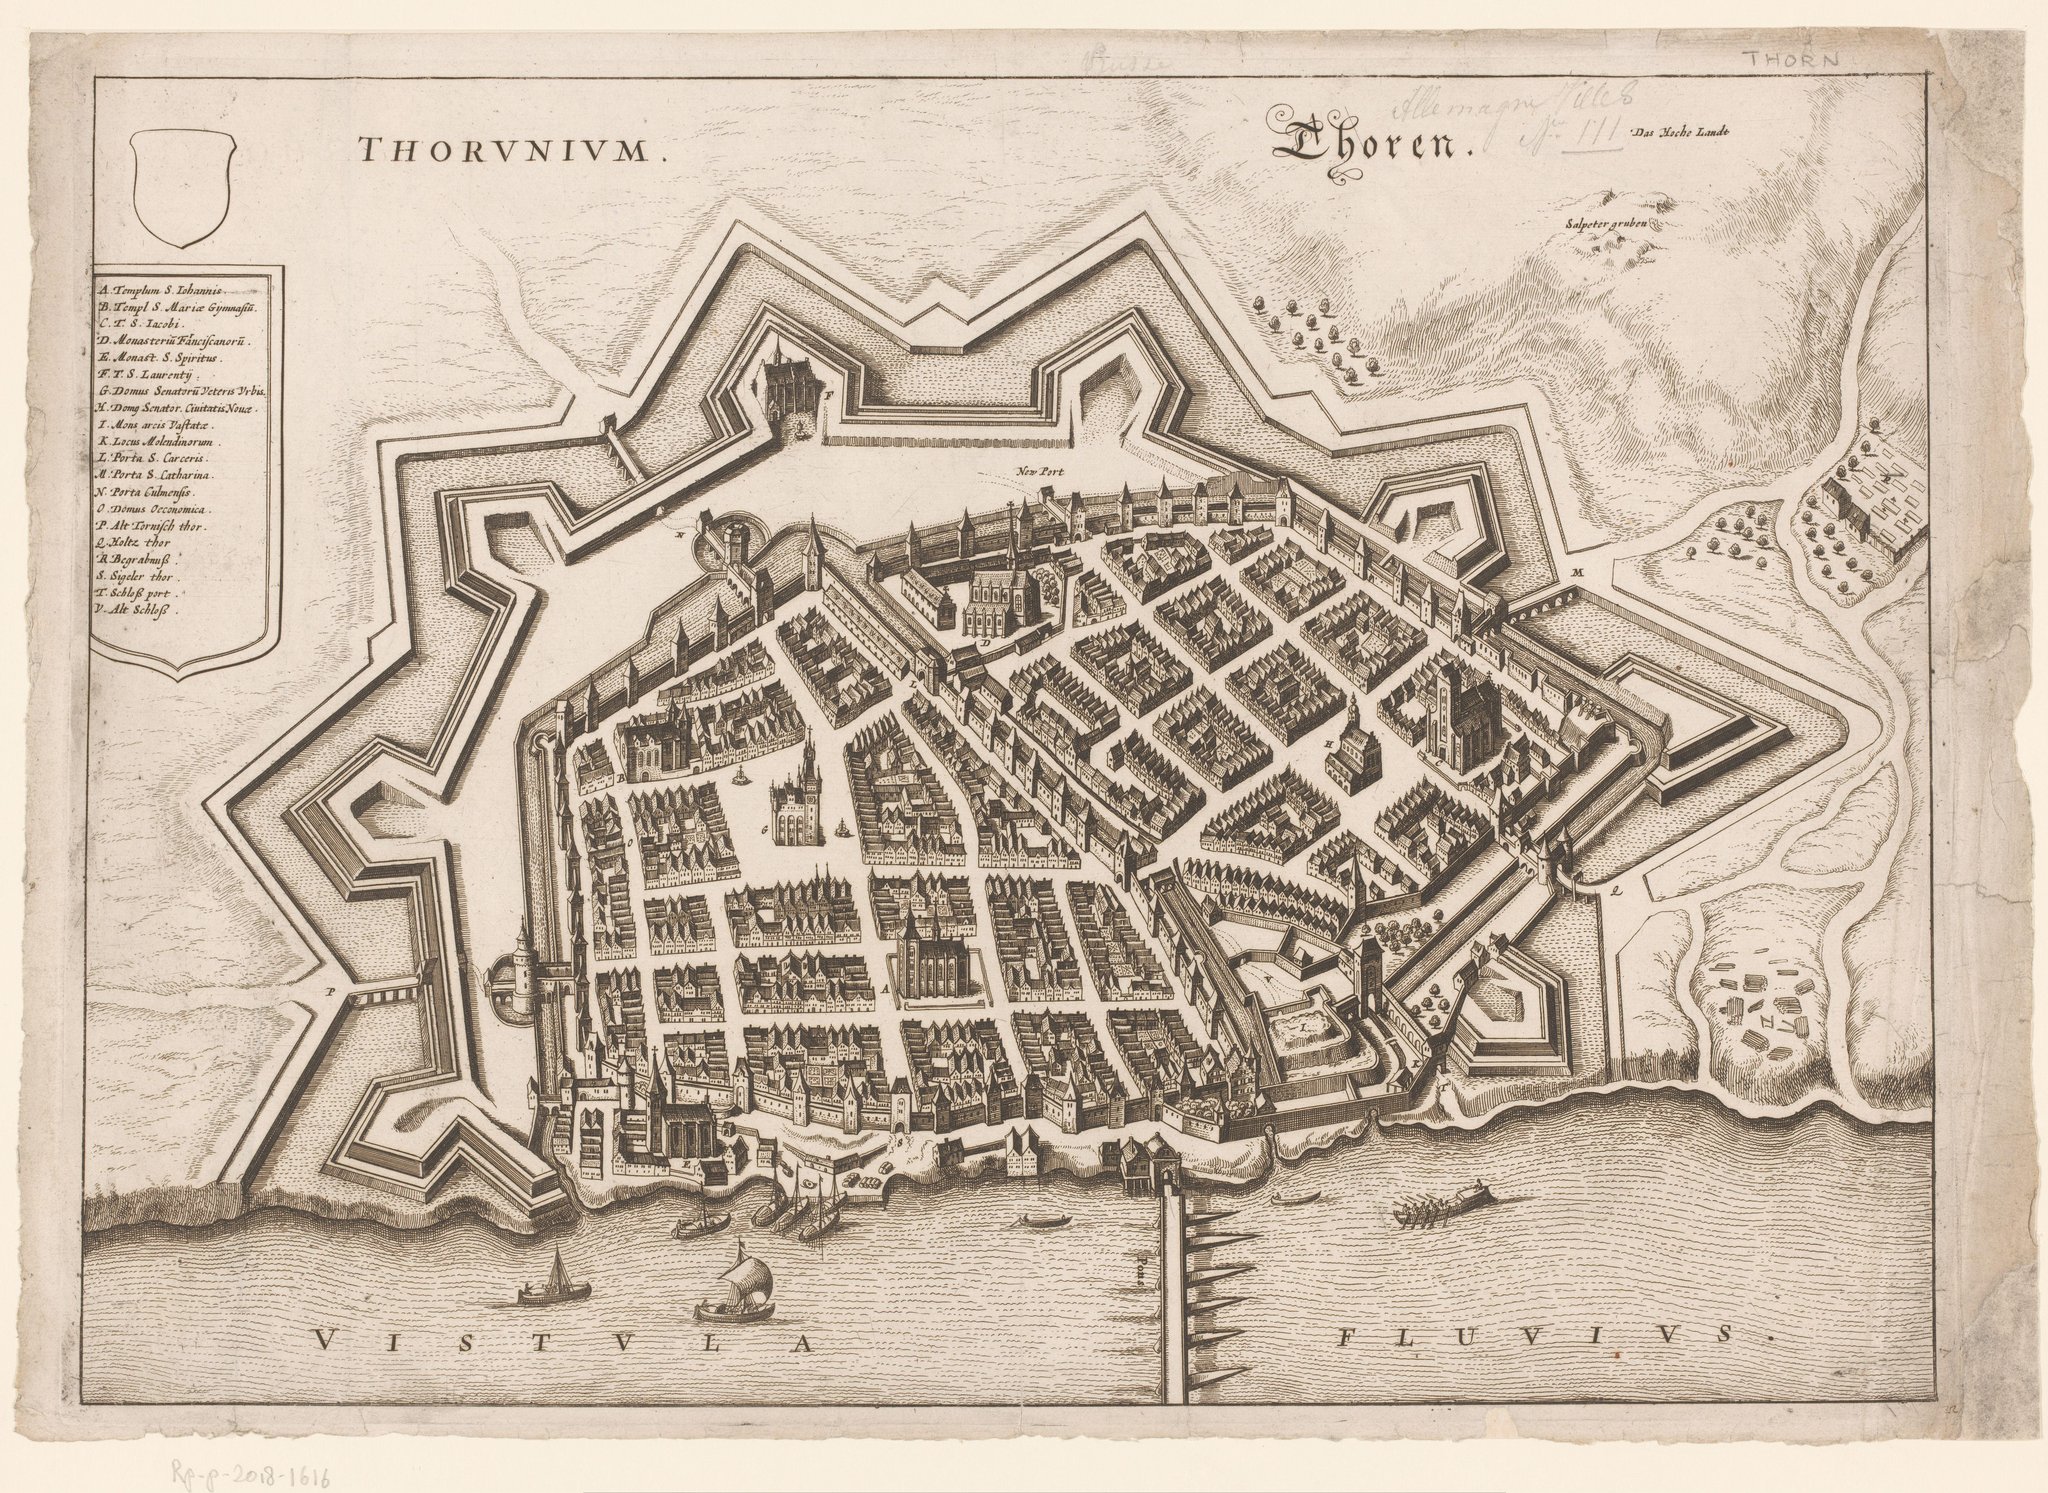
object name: print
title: Plattegrond van Toruń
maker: matthäus merian (i)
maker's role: print maker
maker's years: 1593-1650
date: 1652-1703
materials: paper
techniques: etching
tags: maps of cities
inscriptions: collector's mark: Lugt 2228